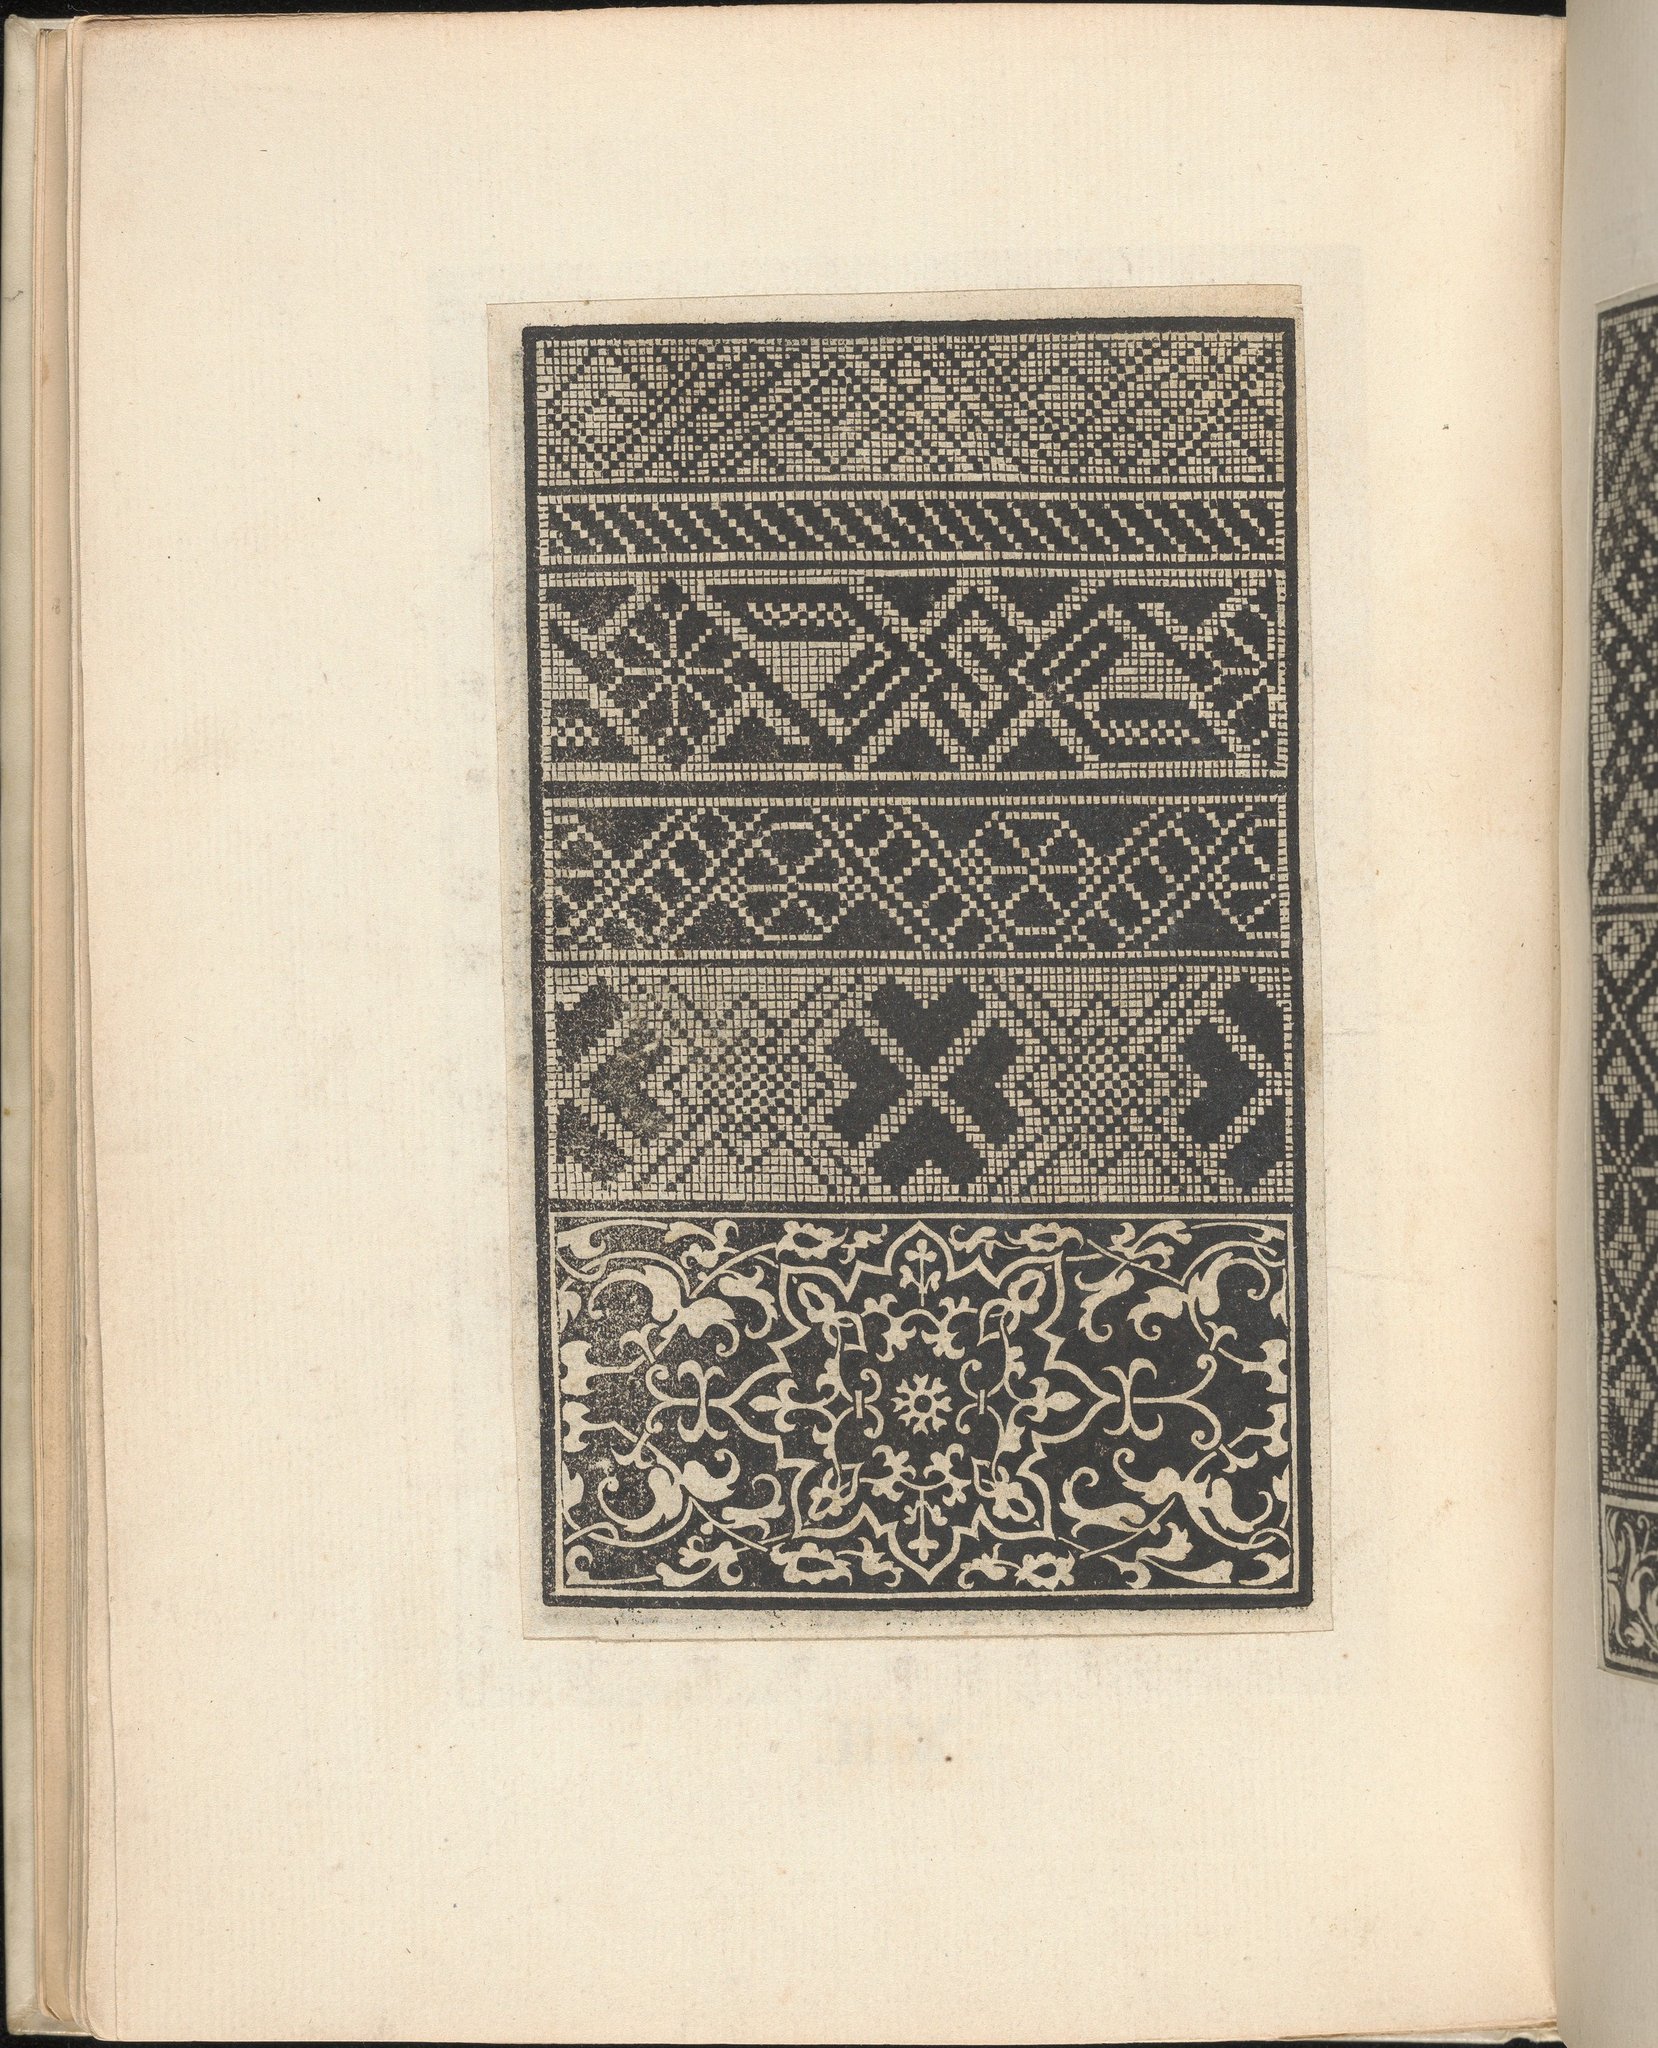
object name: book print ornament architecture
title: Esemplario di lavori, page 13 (verso)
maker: nicolò zoppino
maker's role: publisher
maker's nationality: italian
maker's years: 1478-1544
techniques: bookbinding, inlay, woodcut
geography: italy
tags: ornament